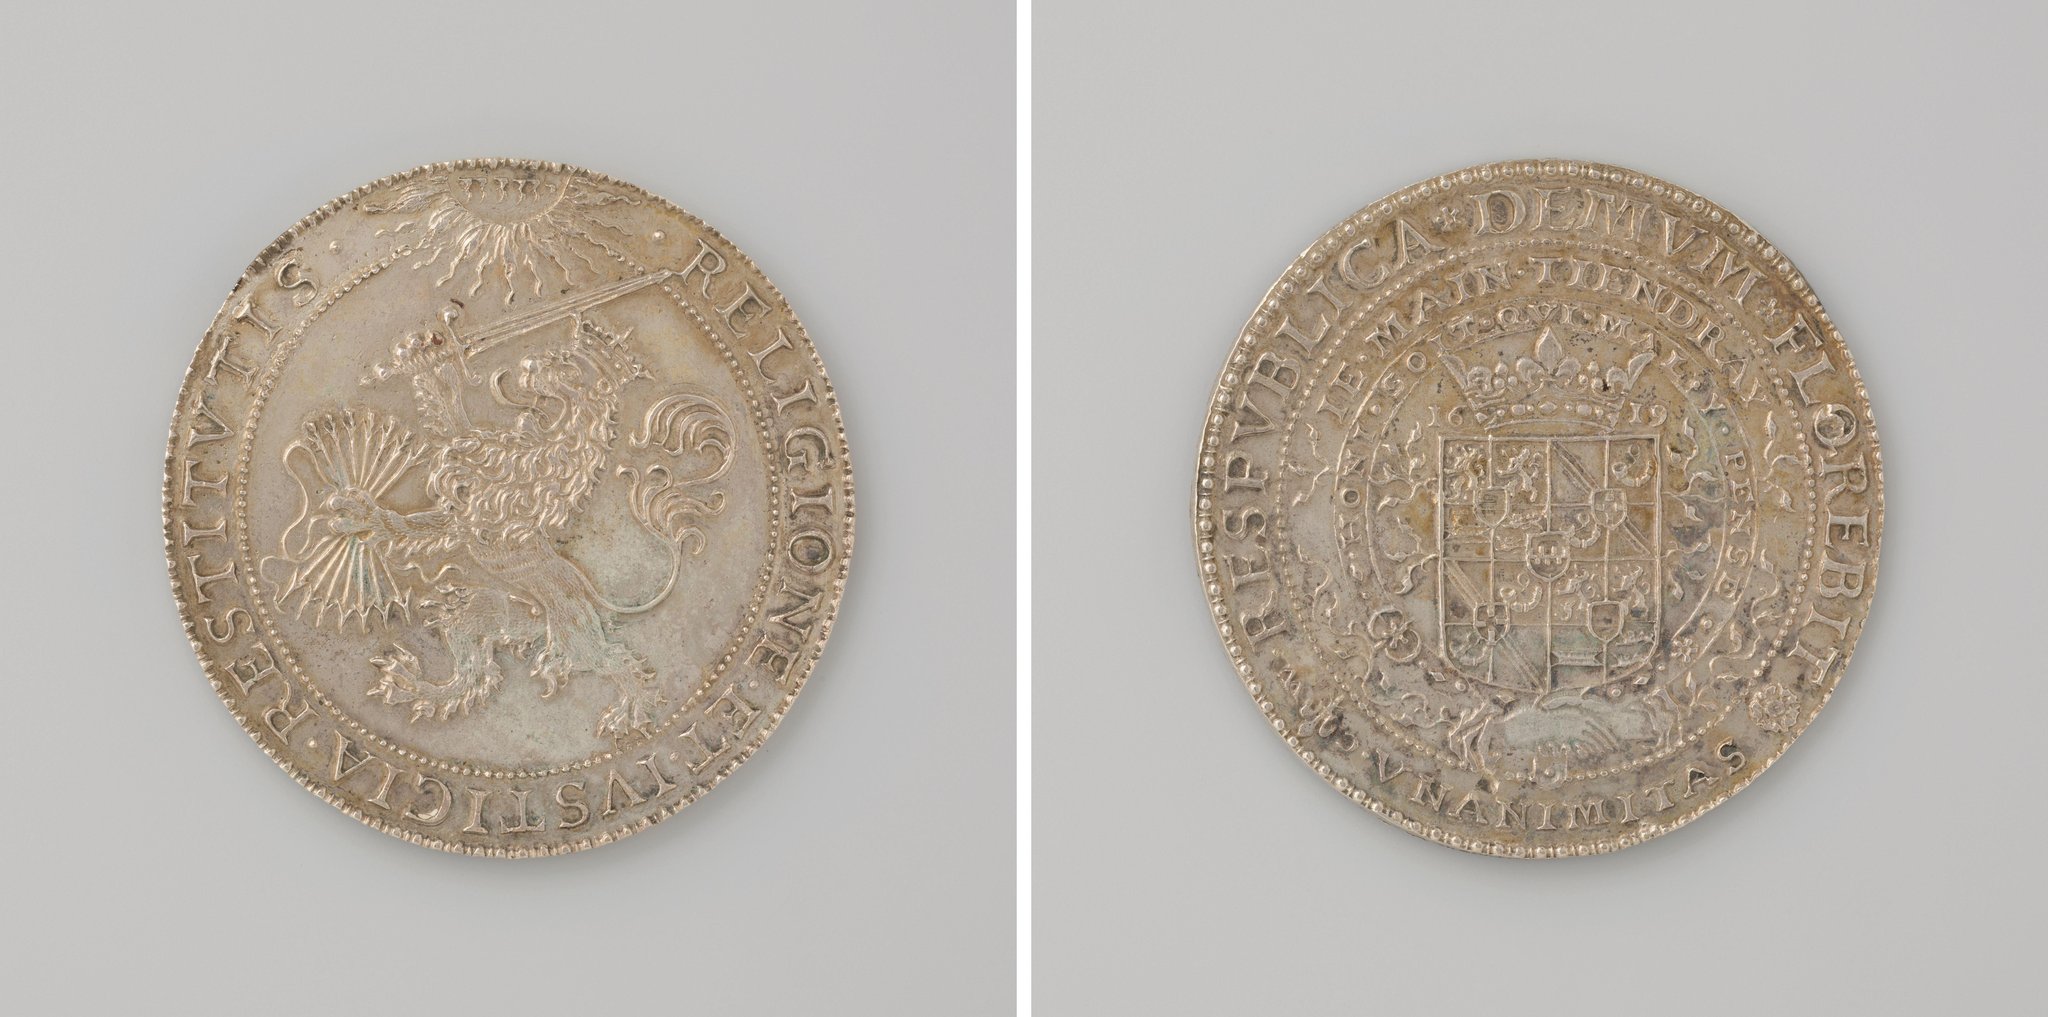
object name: medal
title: Overwinning van de contra-remonstranten (synode van Dordrecht)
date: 1619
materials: silver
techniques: striking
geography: west frisia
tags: remonstranten en contraremonstranten, synode van dordrecht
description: Zilveren penning. Voorzijde: gekroonde leeuw met zwaard en pijlenbundel binnen omschrift. Keerzijde: gekroond wapenschild binnen dubbele spreuk, boven twee ineen geslagen handen en tussen lauwertakken binnen omschrift.